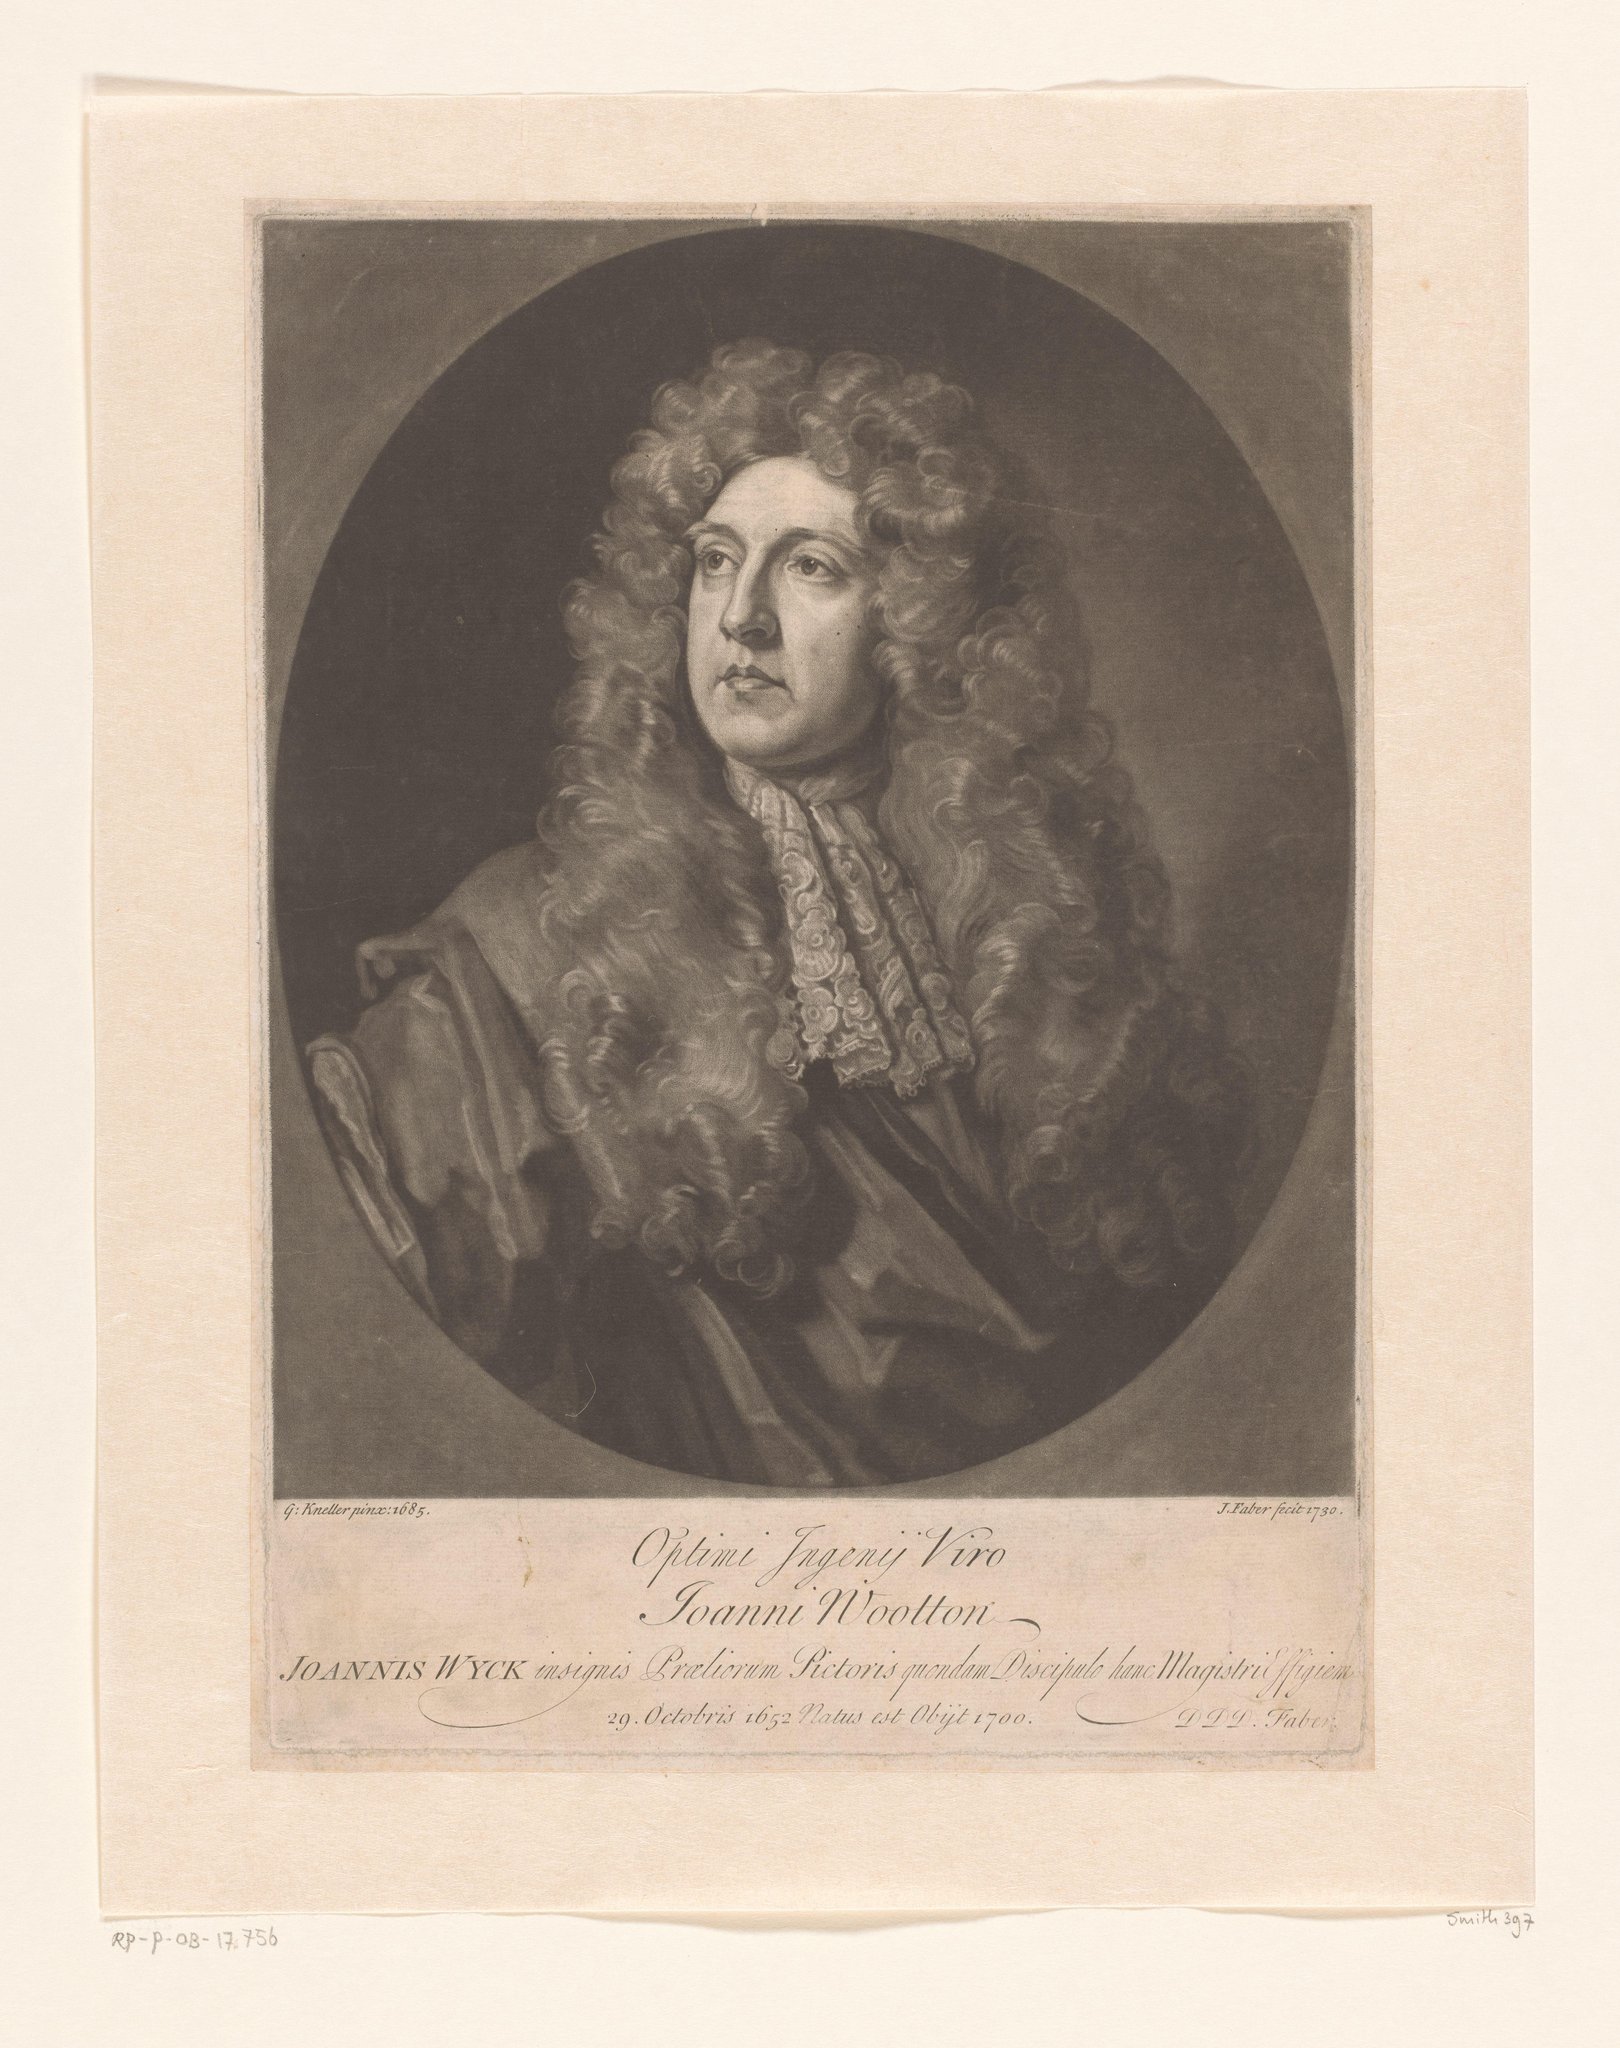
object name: print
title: Portret van Jan Wyck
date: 1730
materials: paper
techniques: etching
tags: jan wyck, historical persons, portrait, self-portrait of painter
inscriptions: collector's mark: Lugt 2228